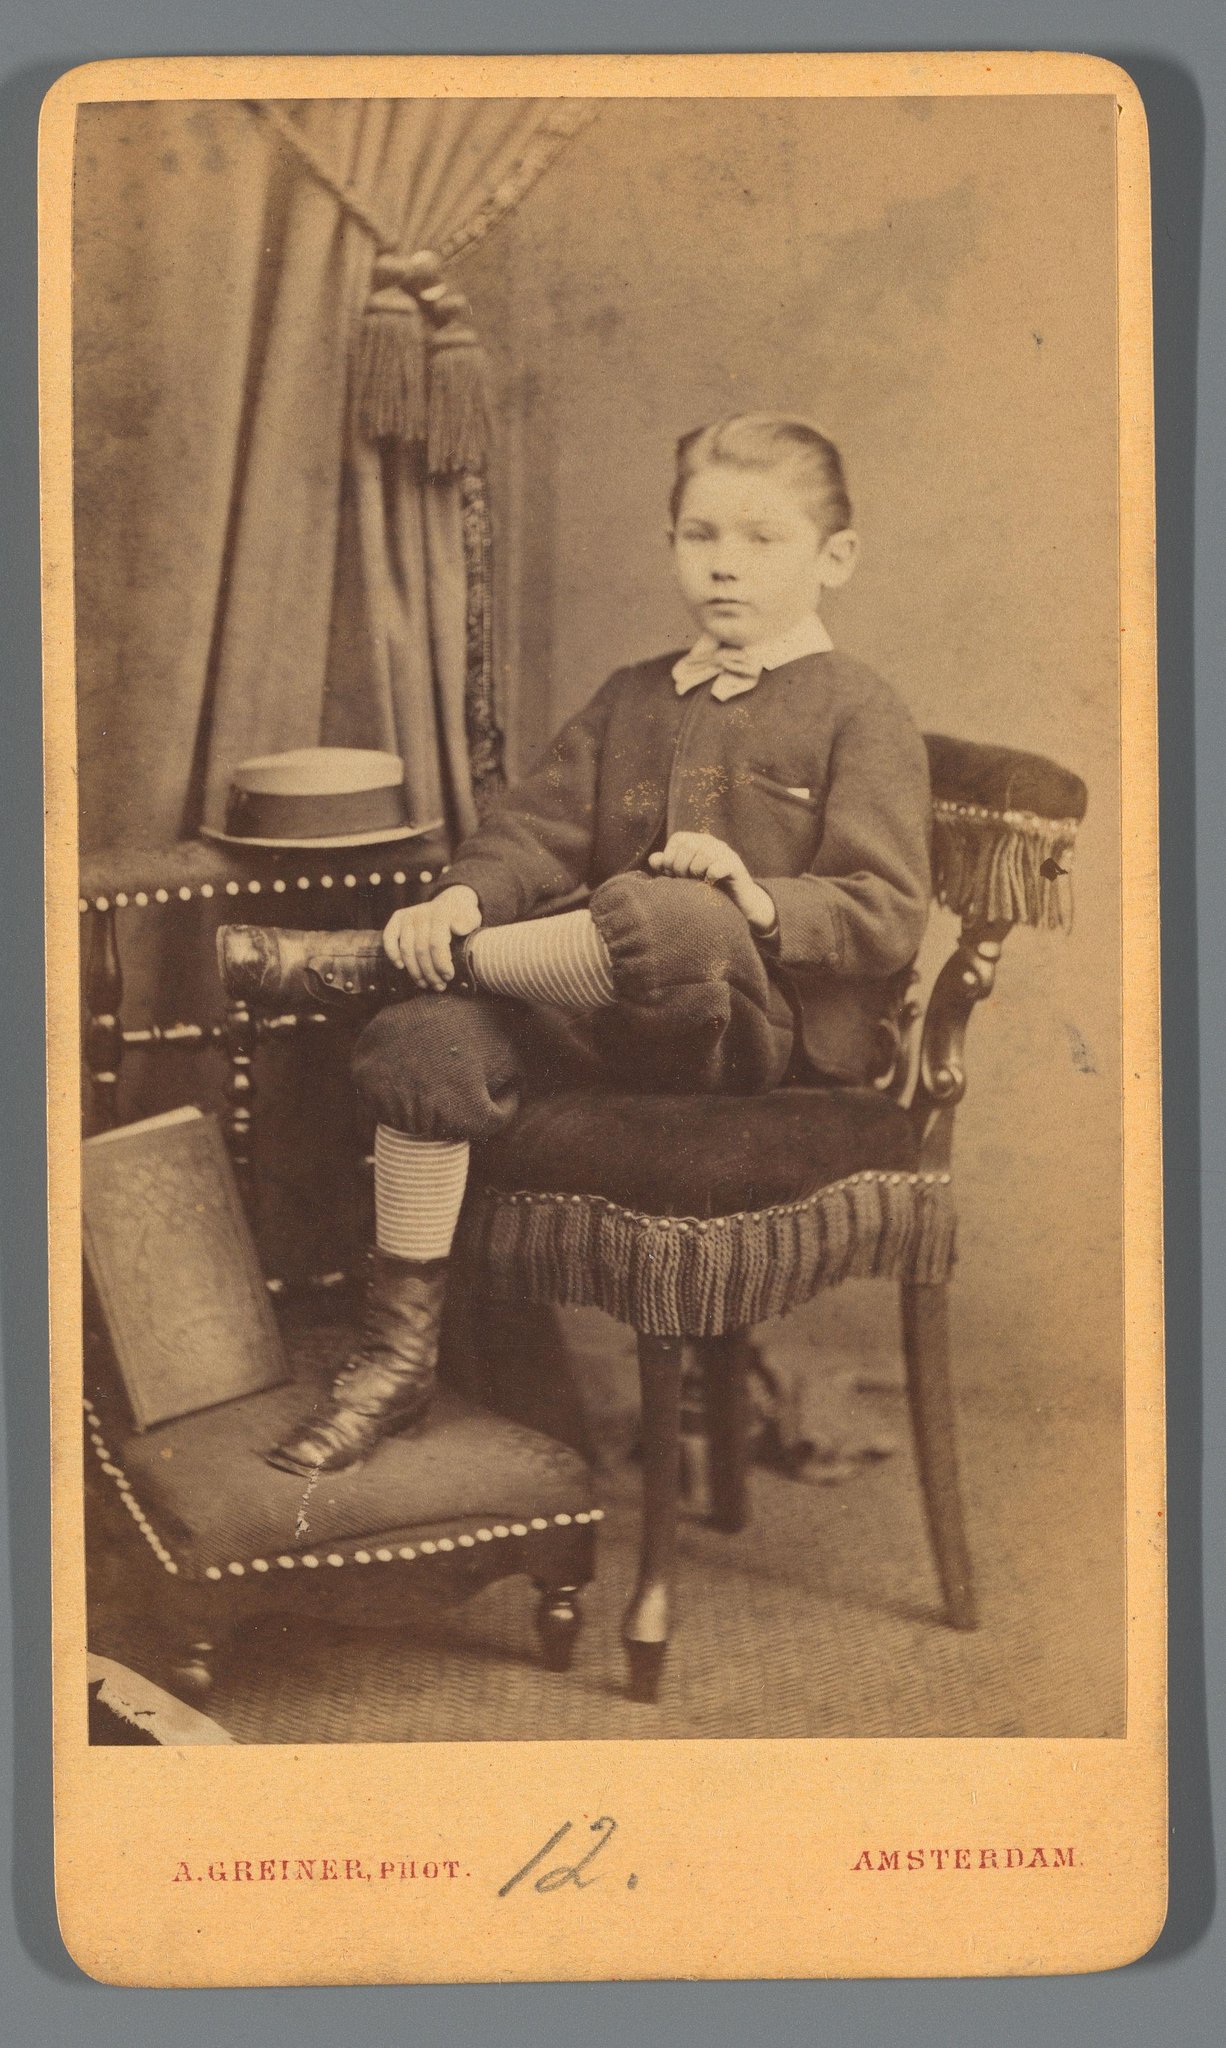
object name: carte de visite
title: Studioportret van Frans Alexander van den Berg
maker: albert greiner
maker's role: fotograaf, fotostudio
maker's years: 1833-1890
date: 1855-1890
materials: cardboard, photographic support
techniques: albumen print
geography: amsterdam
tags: batavia, amsterdam, frans alexander van den berg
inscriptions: name: ‘Berg.’, name: ‘A. GREINER, PHOT. 12. AMSTERDAM.’, inscription: ‘A. GREINER / Photograf / NIEUWENDIJK . L. 87 / AMSTERDAM’